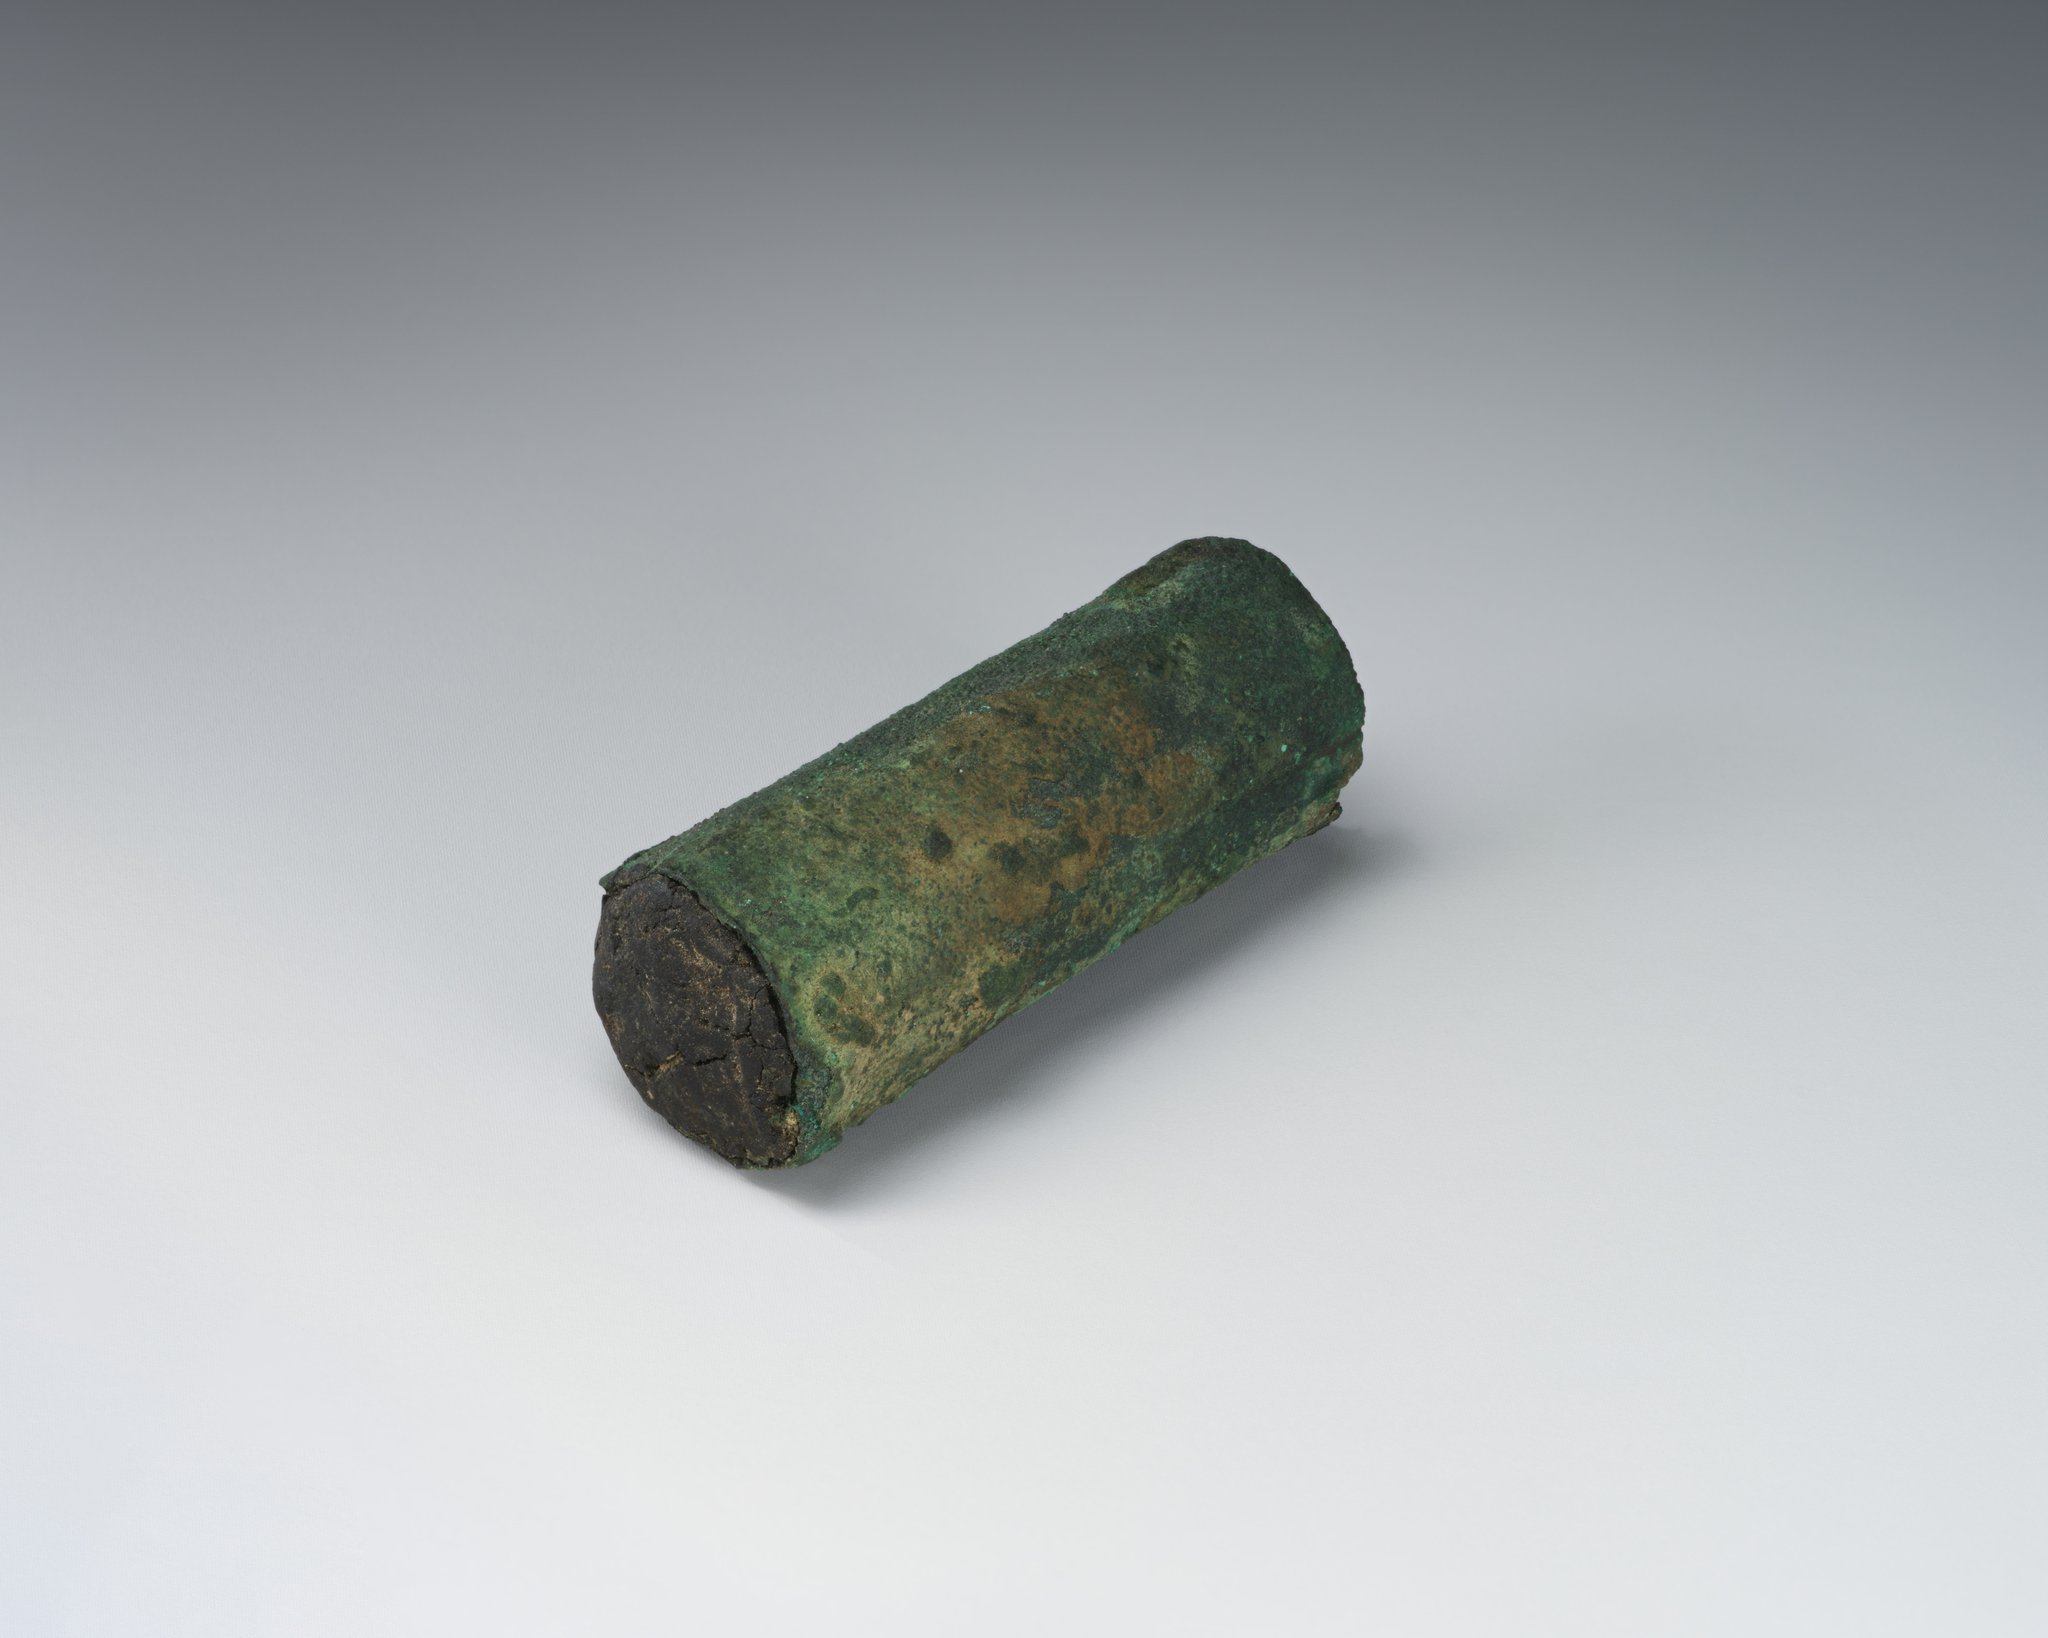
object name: amulet case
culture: sasanian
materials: copper, patina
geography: mesopotamia